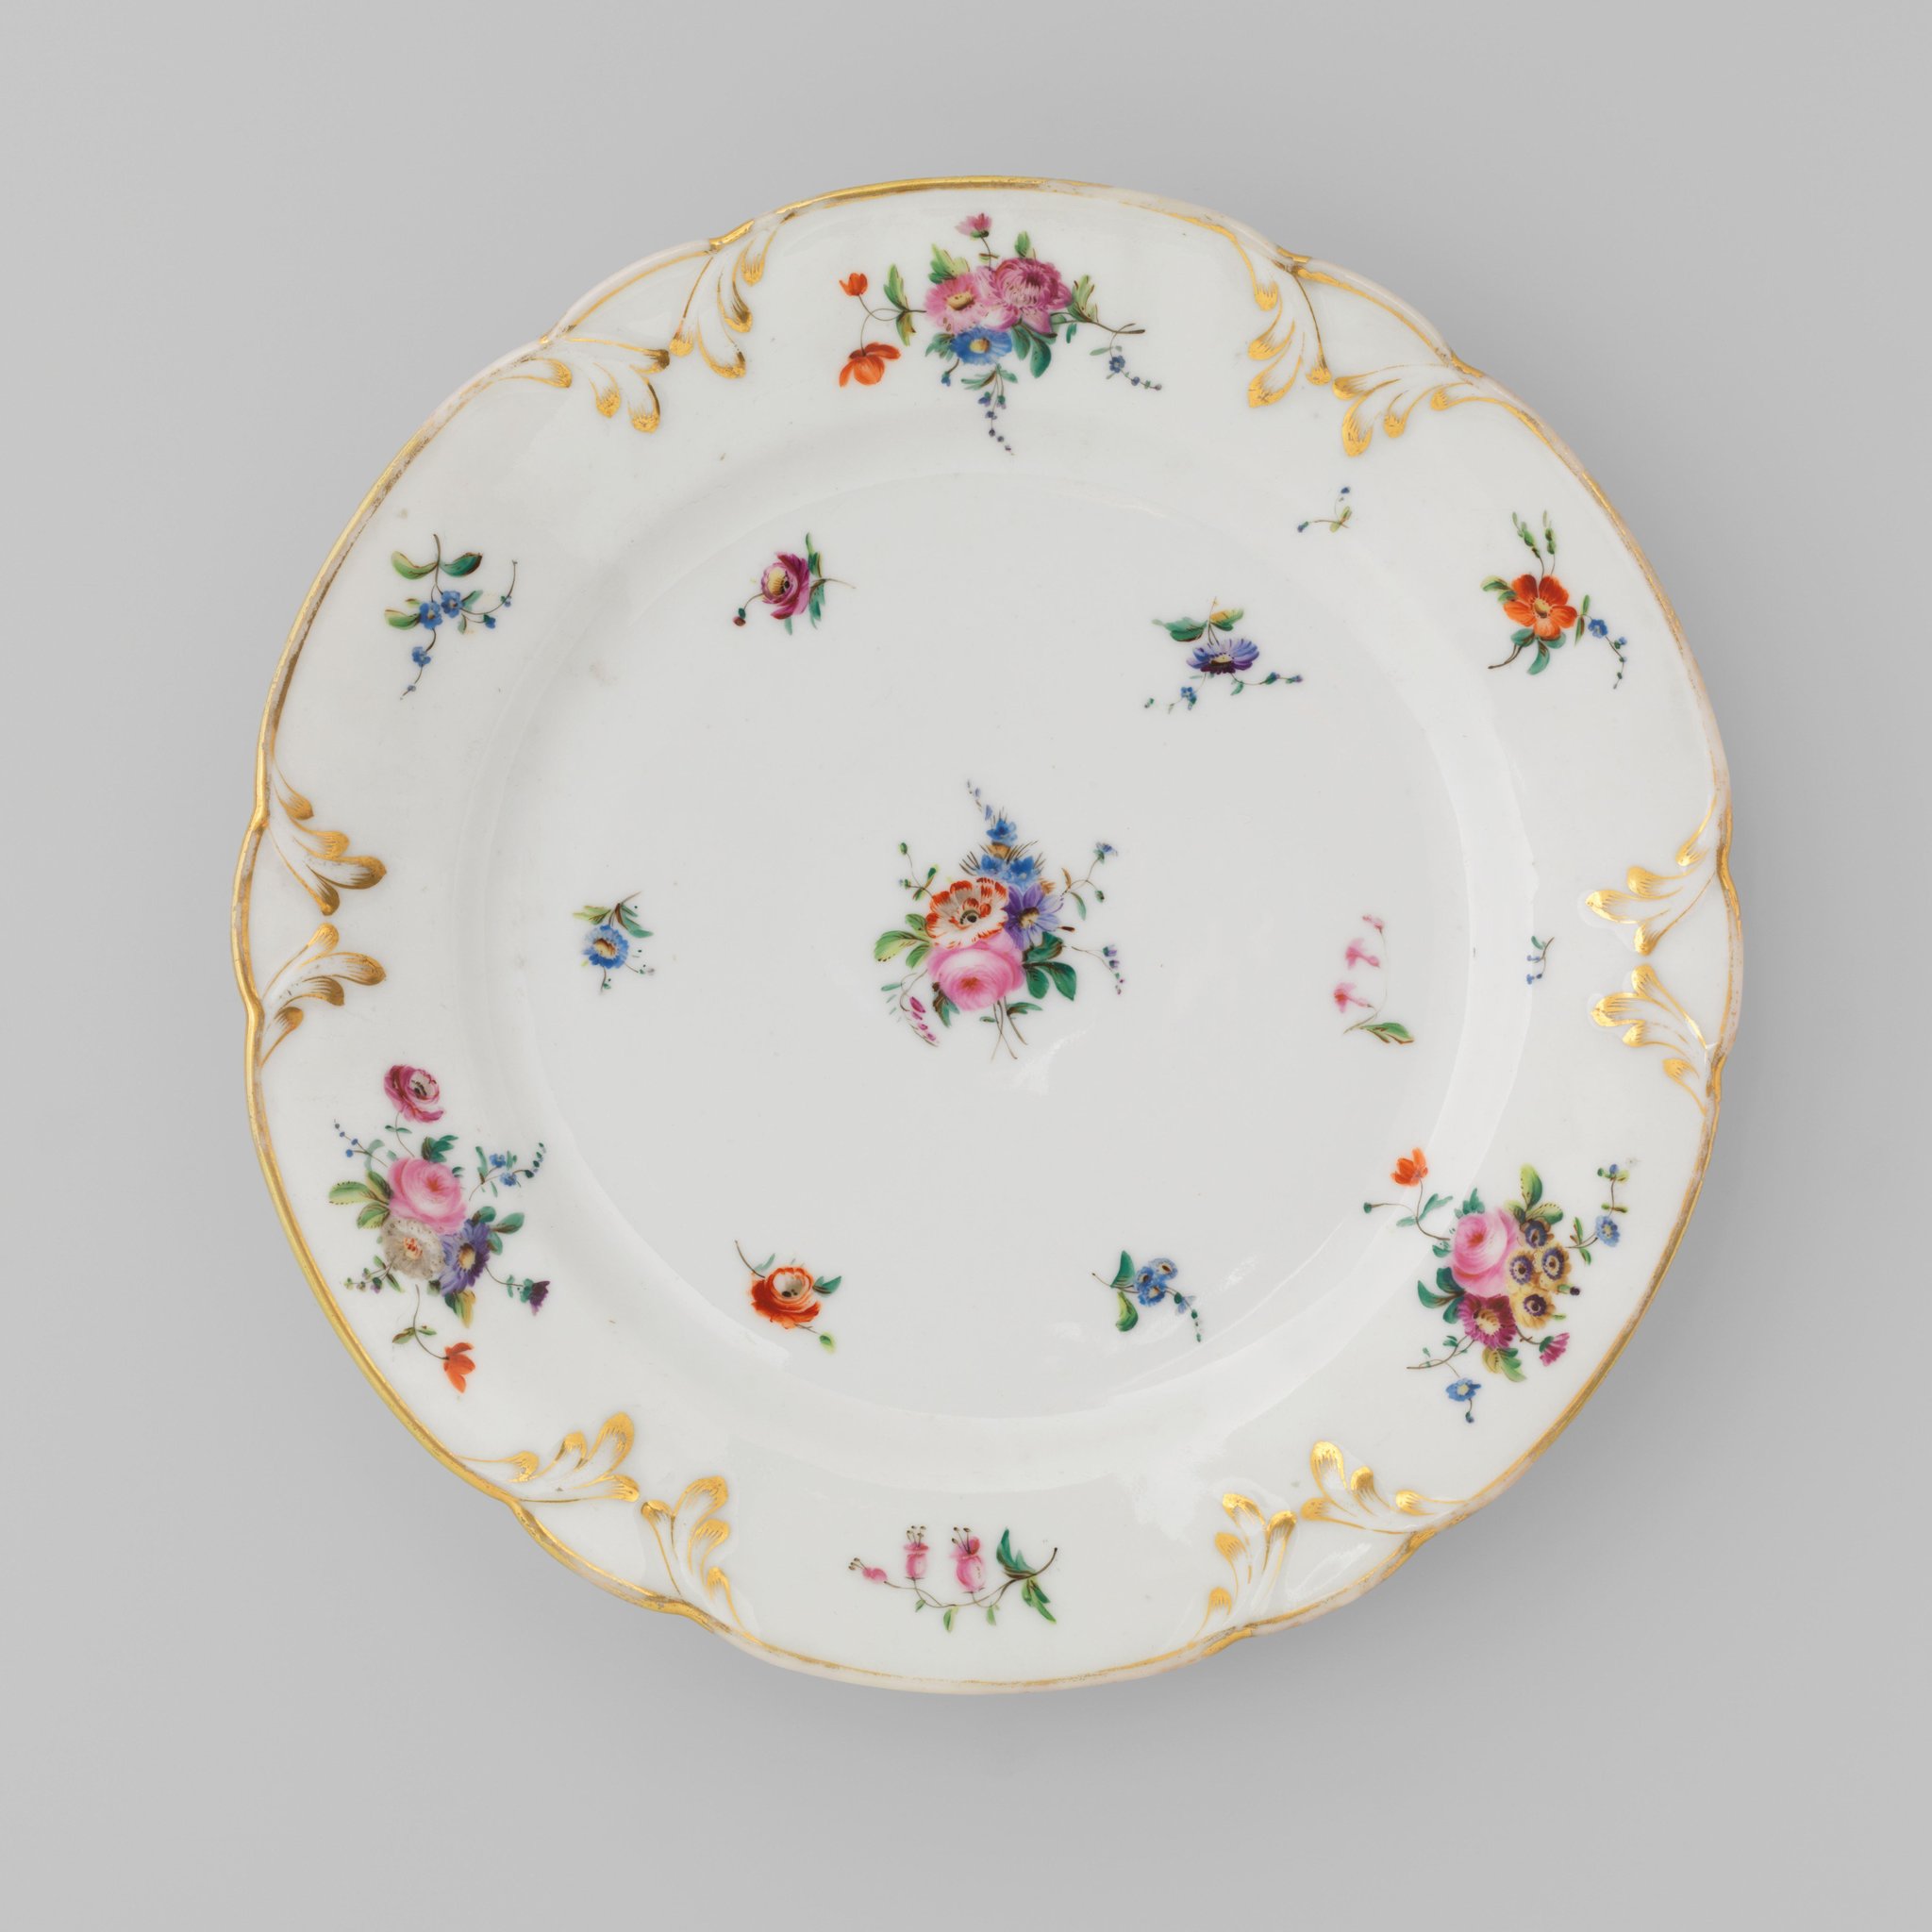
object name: plate dish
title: Plate with bouquets and flower sprays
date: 1839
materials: glaze, gold, paint, porcelain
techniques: firing, forming, gilding, turning, vitrification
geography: paris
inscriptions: mark: ‘DENUELLE/ Boulevard St. Denis 18/ à Paris’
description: Bord van porselein met een gelobde rand, beschilderd op het glazuur in blauw, rood, roze, groen, geel, paars, zwart en goud. Op het plat boeketten van verschillende bloemen en strooibloemen. Vanuit de gelobde, gouden rand, gemodelleerde bladranken in reliëf, aangezet met goud. Hiertussen boeketten. Drie proenen op de onderzijde. Gemerkt op de onderzijde met 'DENUELLE/ Boulevard St. Denis 18/ à Paris'.